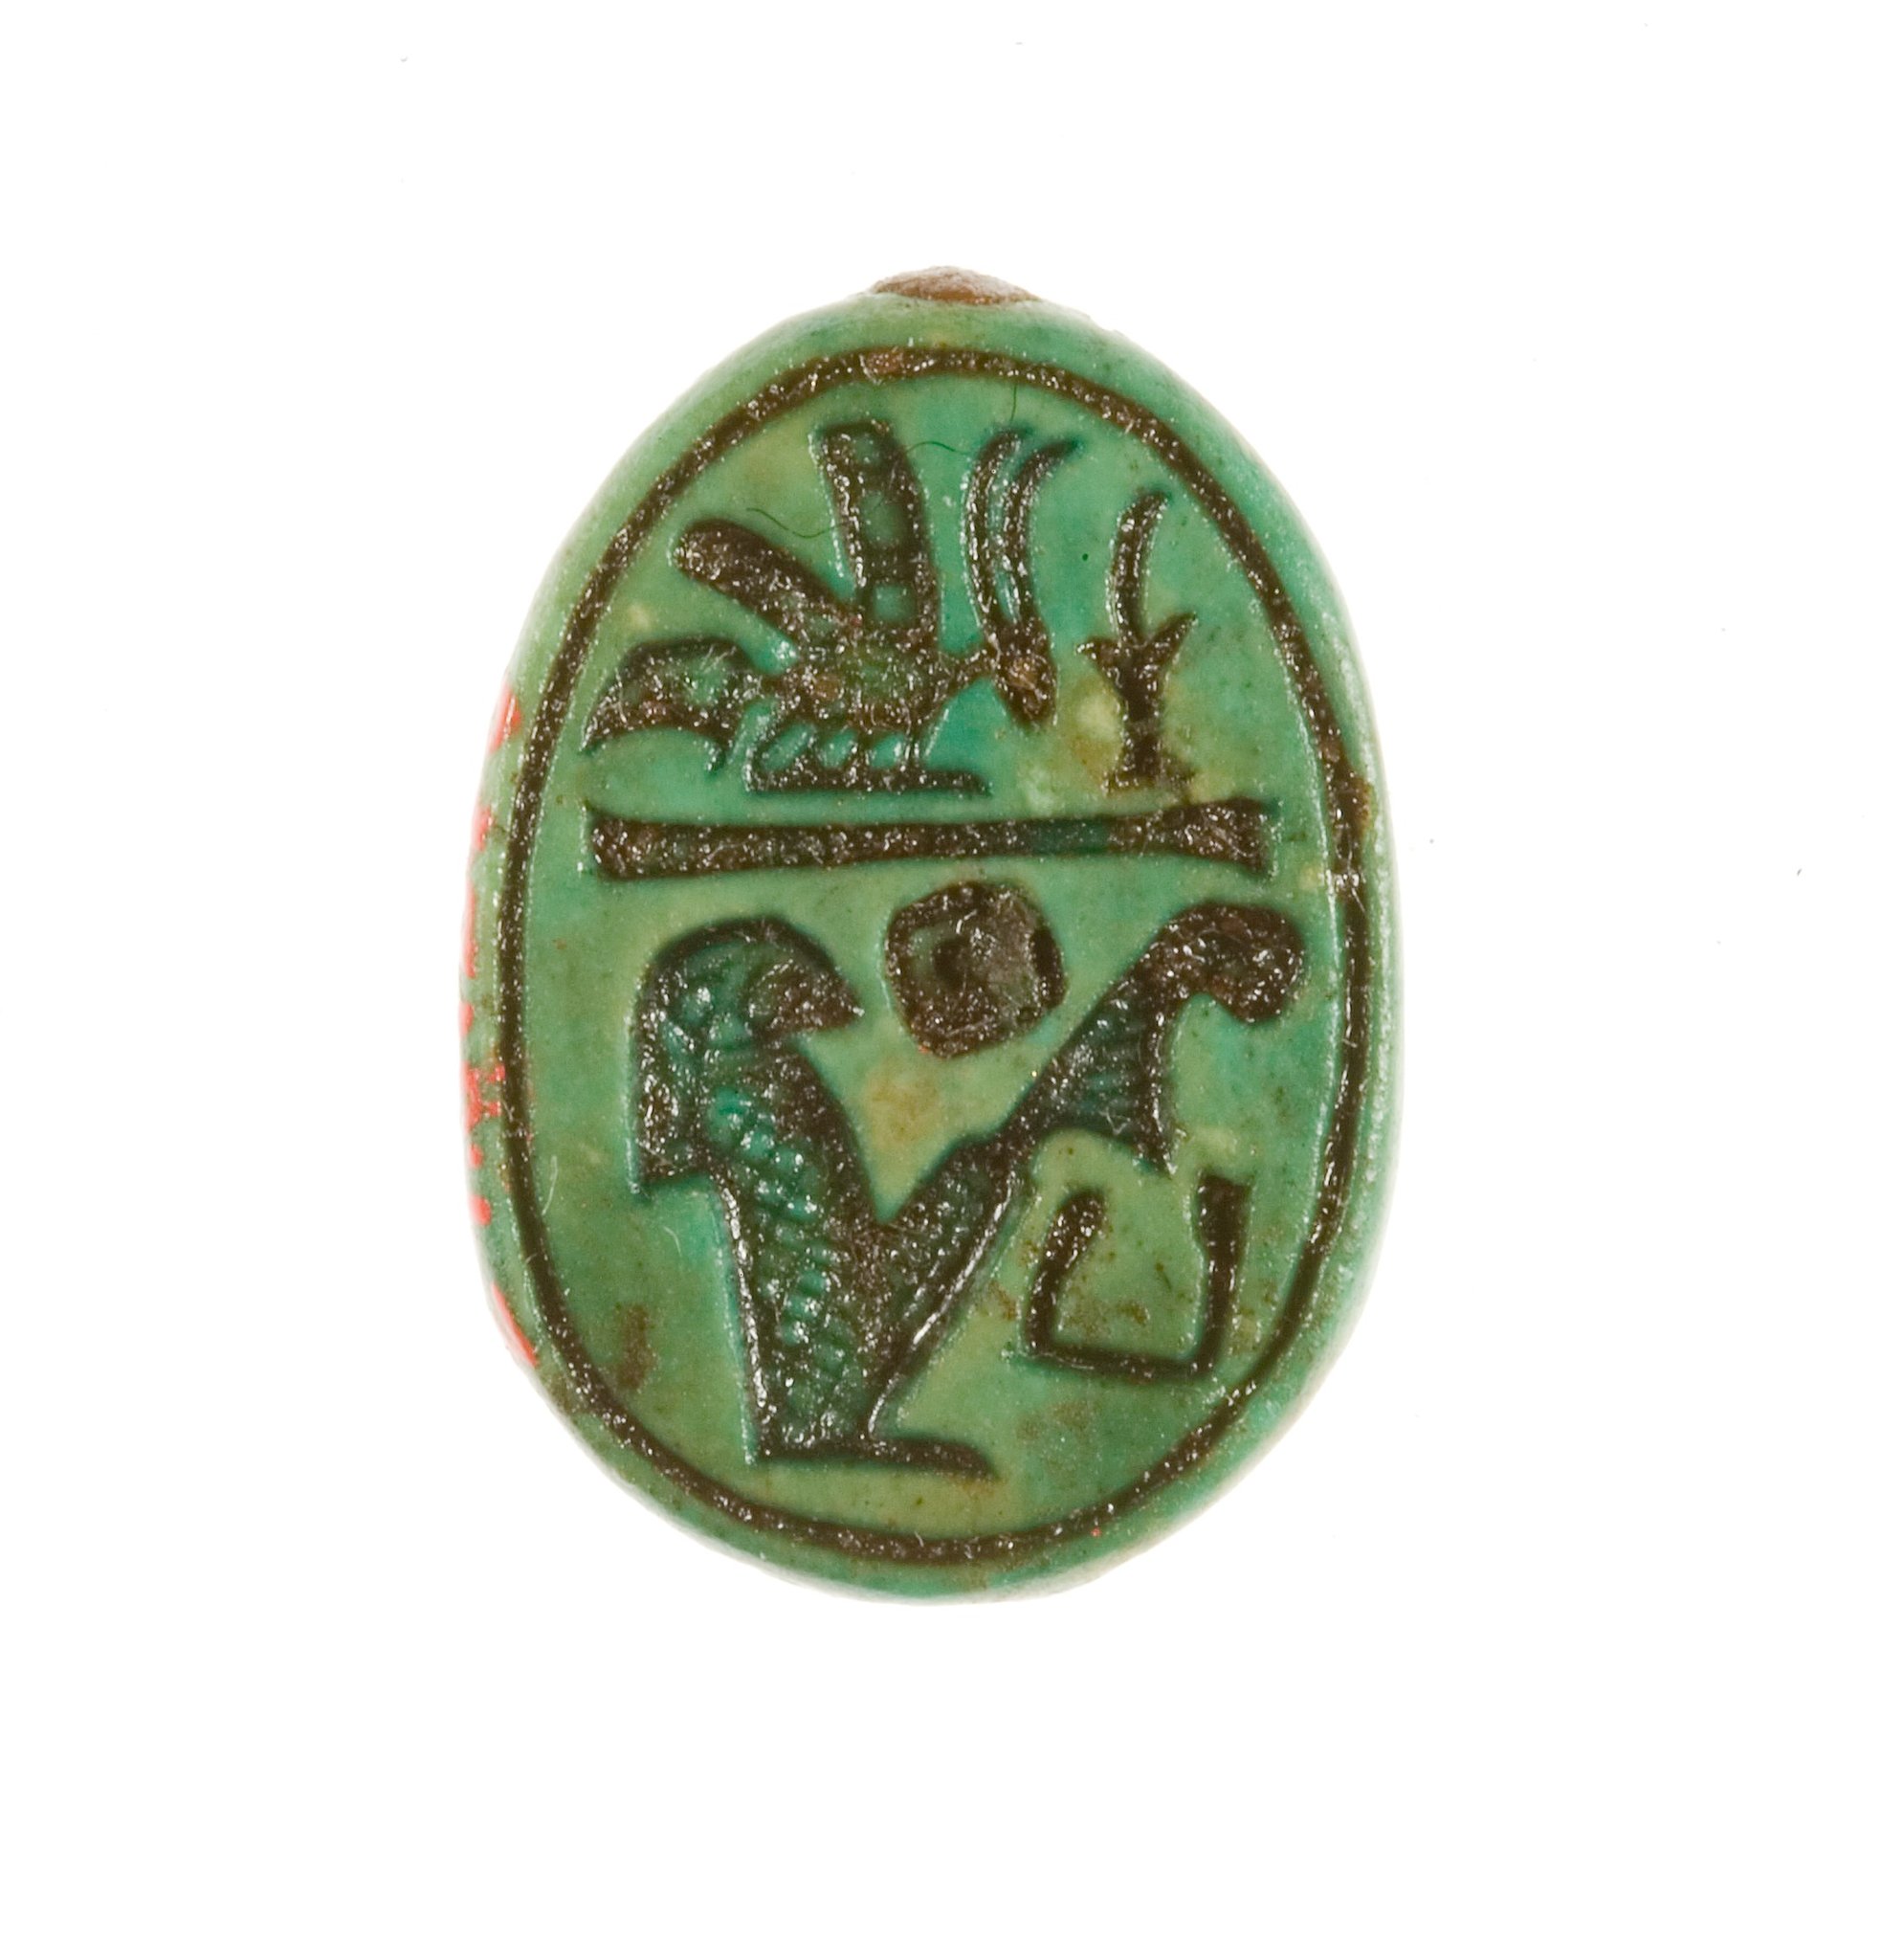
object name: scarab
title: Scarab Inscribed for the King of Upper and Lower Egypt Maatkare (Hatshepsut)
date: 1479-1458 BCE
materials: stone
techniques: glazing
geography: egypt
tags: hieroglyphs,scarabs